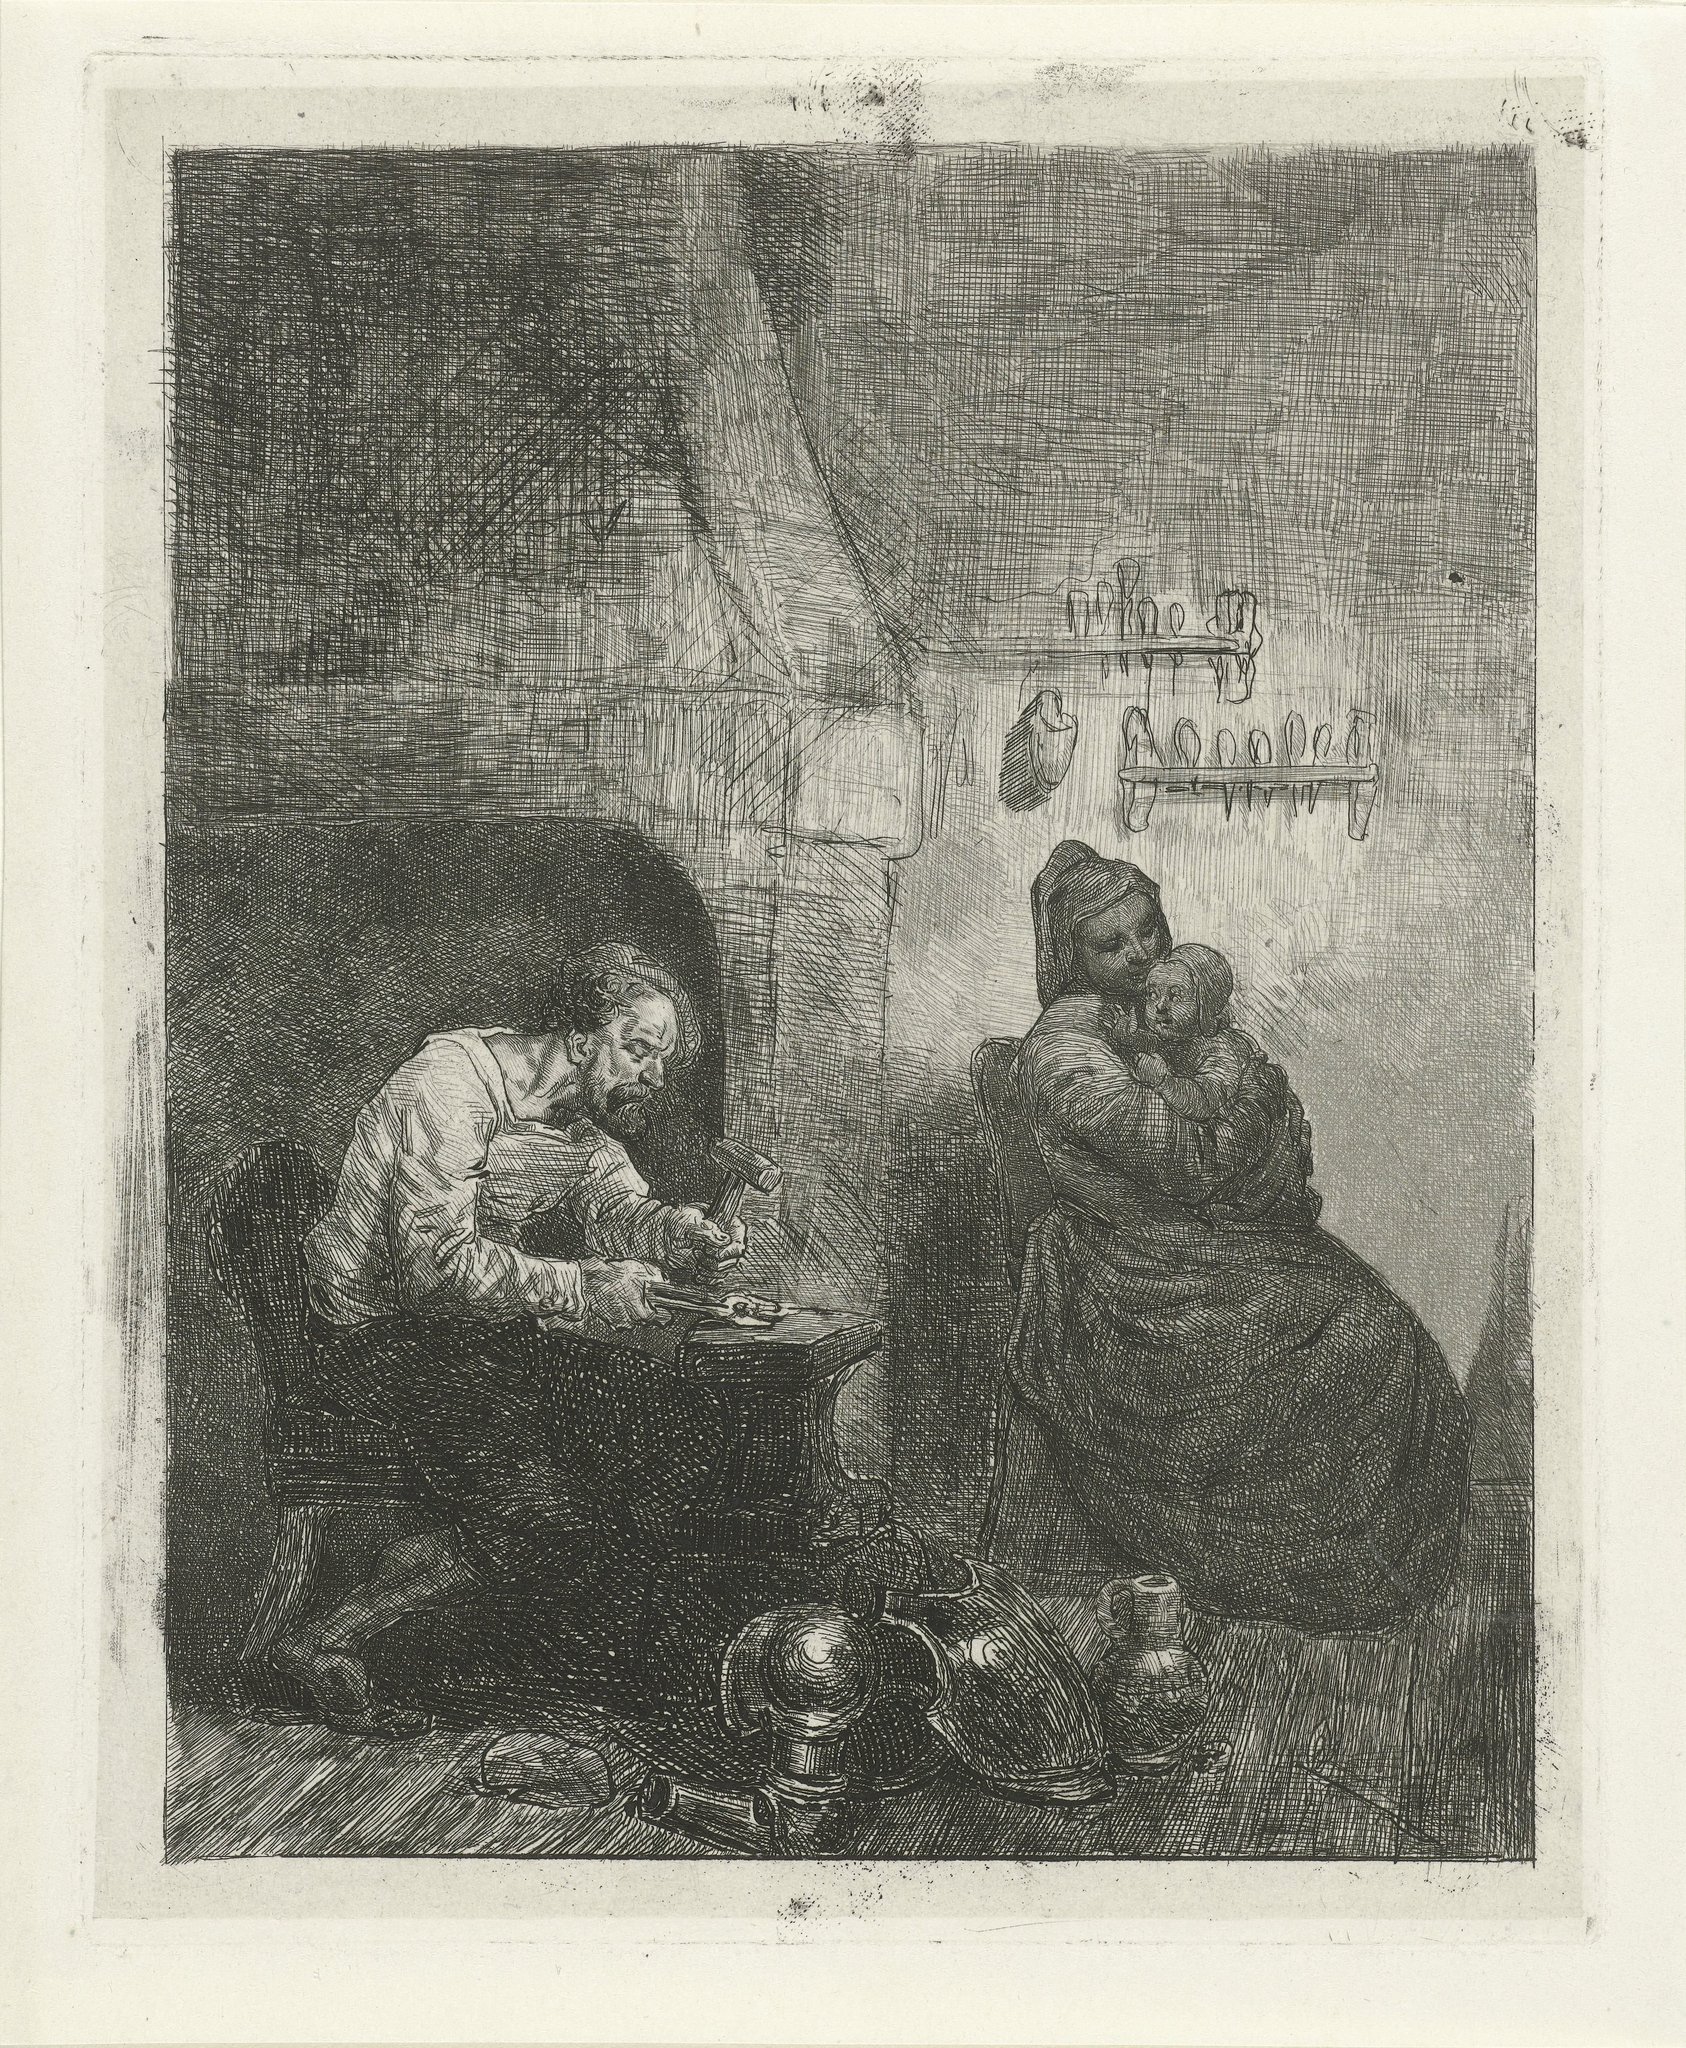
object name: print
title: Wapensmid aan het werk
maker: reinier craeyvanger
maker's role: draughtsman, print maker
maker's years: 1812-1880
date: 1822-1880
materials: paper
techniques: etching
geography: amsterdam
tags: smith, blacksmith (+ indoors; in laboratory, factory, barn, etc.), armour, mother and baby or young child, handicrafts ~ metal, forging (industrial process)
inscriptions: collector's mark: Lugt 2760, collector's mark: Lugt 2228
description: Een wapensmid zit op een stoel voor een aambeeld en bewerkt met een hamer een voorwerp dat hij in een tang vasthoudt. Naast het aambeeld liggen delen van een harnas. Achter hem een haard. Rechts zit zijn vrouw met een kind in de armen.